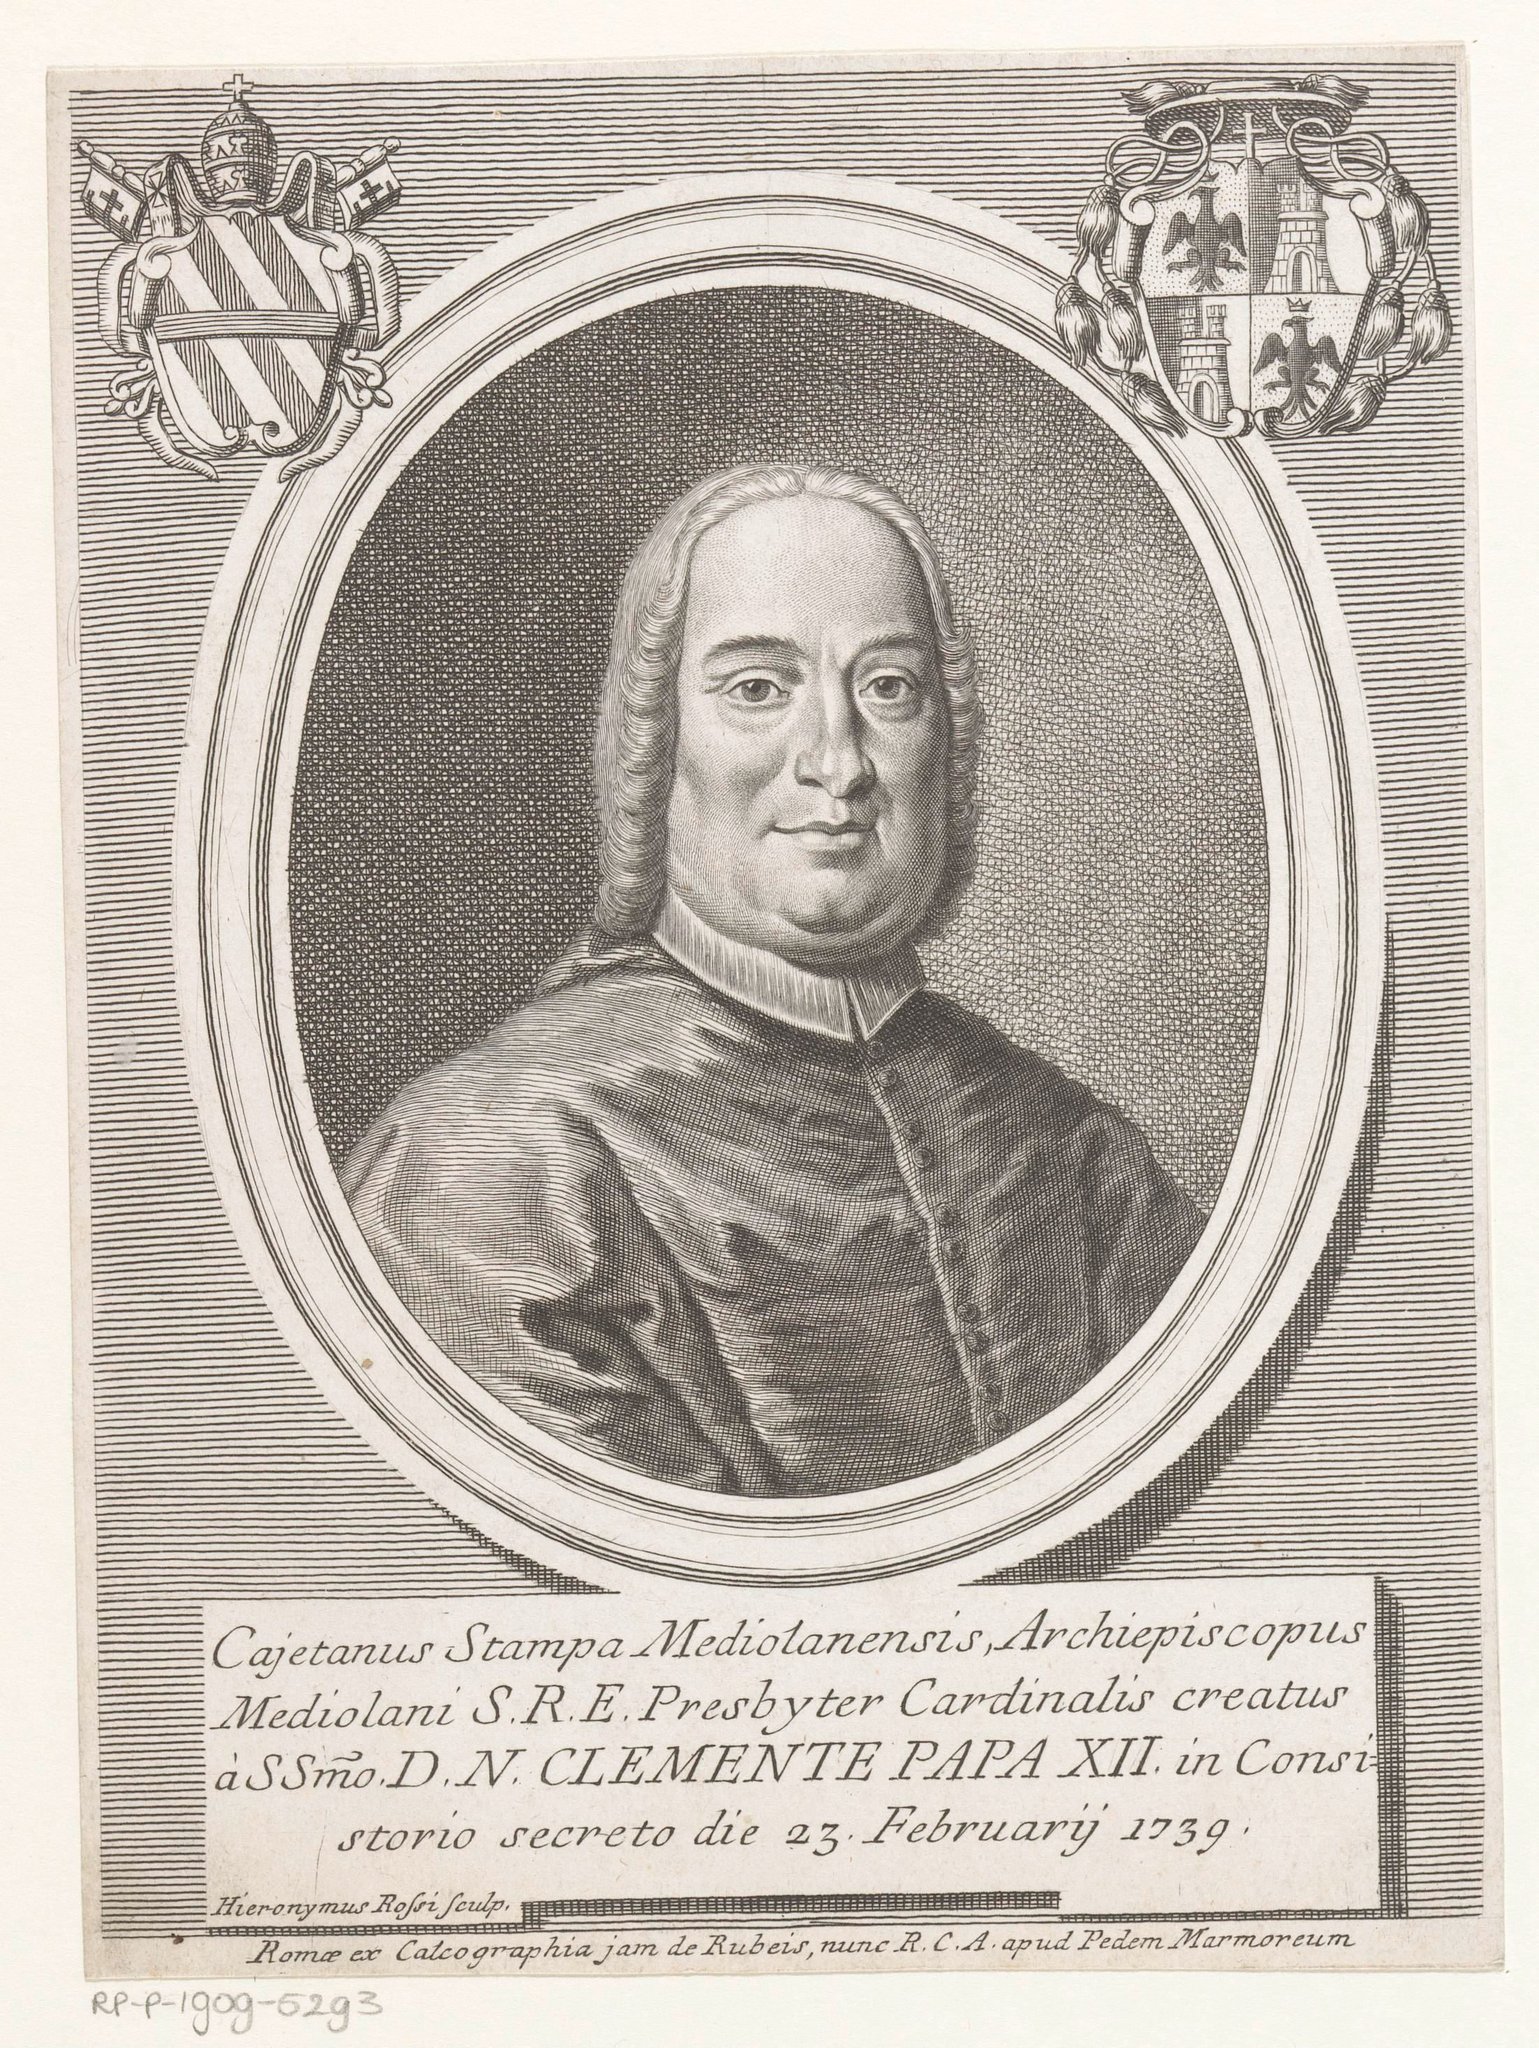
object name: print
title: Portret van kardinaal Gaetano Stampa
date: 1739-1762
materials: paper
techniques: engraving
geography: vatican city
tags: gaetano stampa, cardinal, historical persons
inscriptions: collector's mark: Lugt 2228